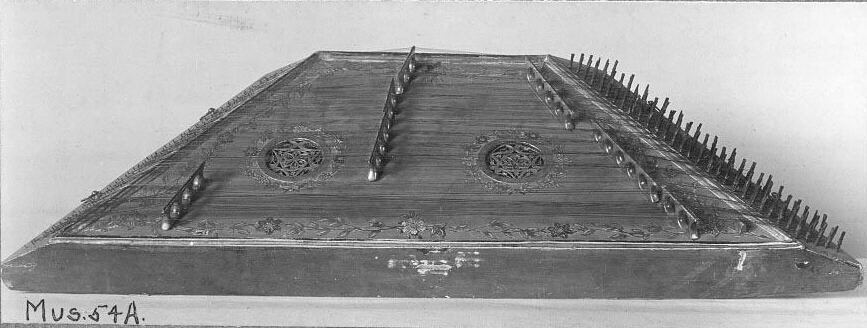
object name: dulcimer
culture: spanish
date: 1701-1800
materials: wood